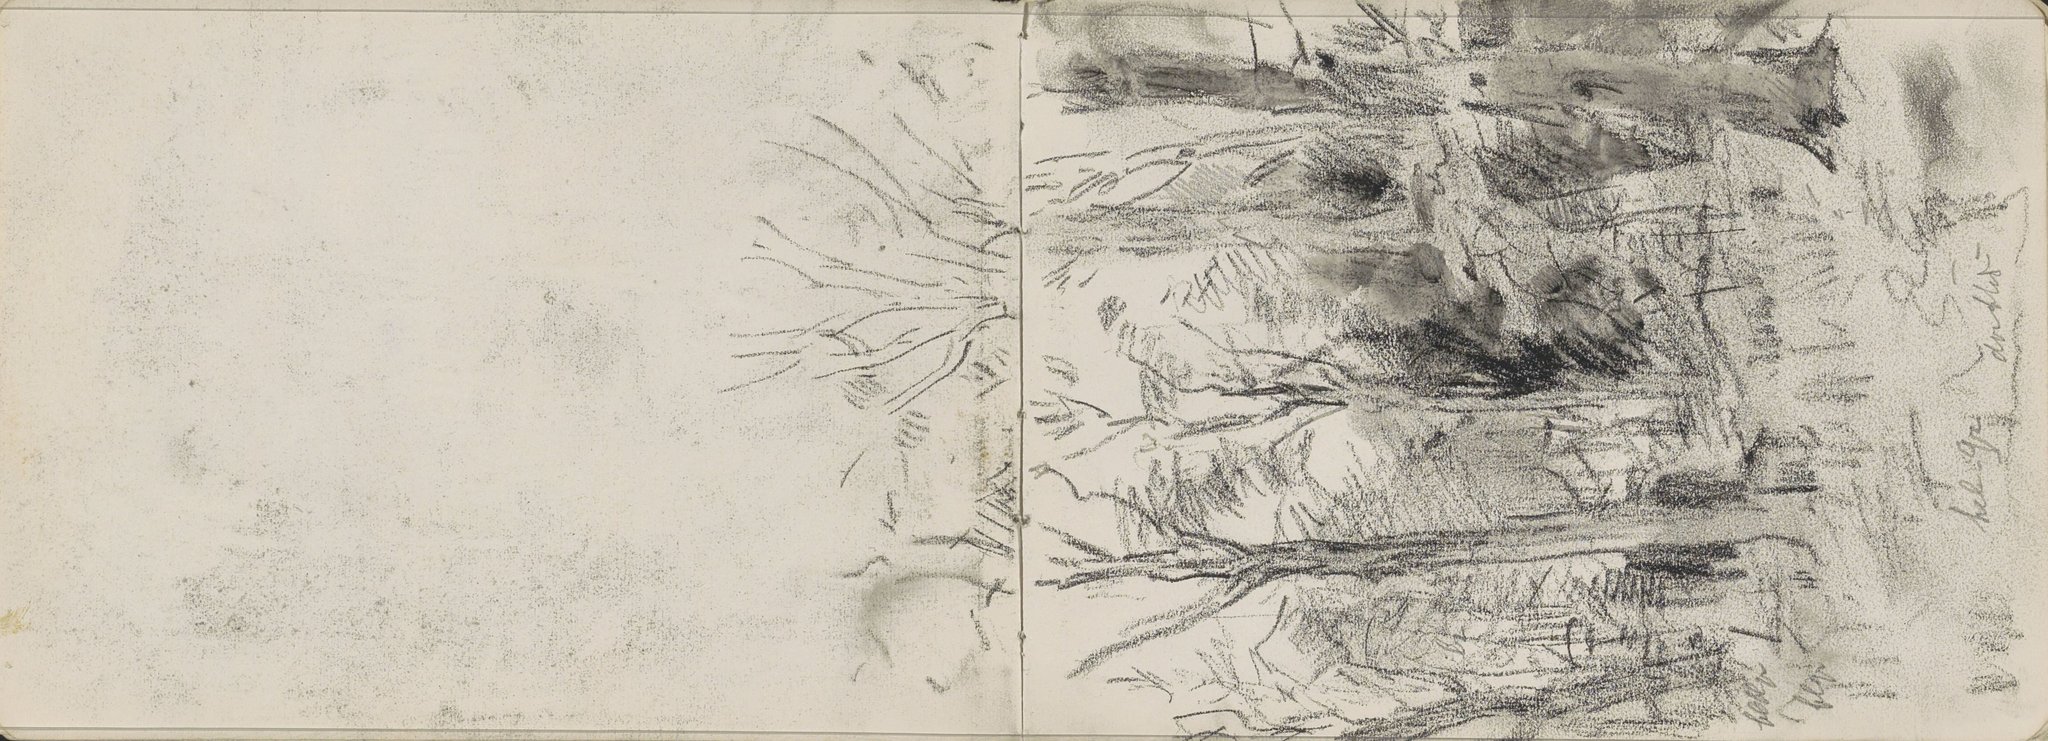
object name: sketchbook leaf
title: Bosgezicht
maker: johan antonie de jonge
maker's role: draughtsman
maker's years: 1864-1927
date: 1881-1927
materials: chalk, paper, pencil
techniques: stumping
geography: south holland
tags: forest, wood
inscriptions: kleurnotitie, handgeschreven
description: Bosgezicht. Blad 2 verso en blad 3 recto uit een schetsboek met 28 bladen.